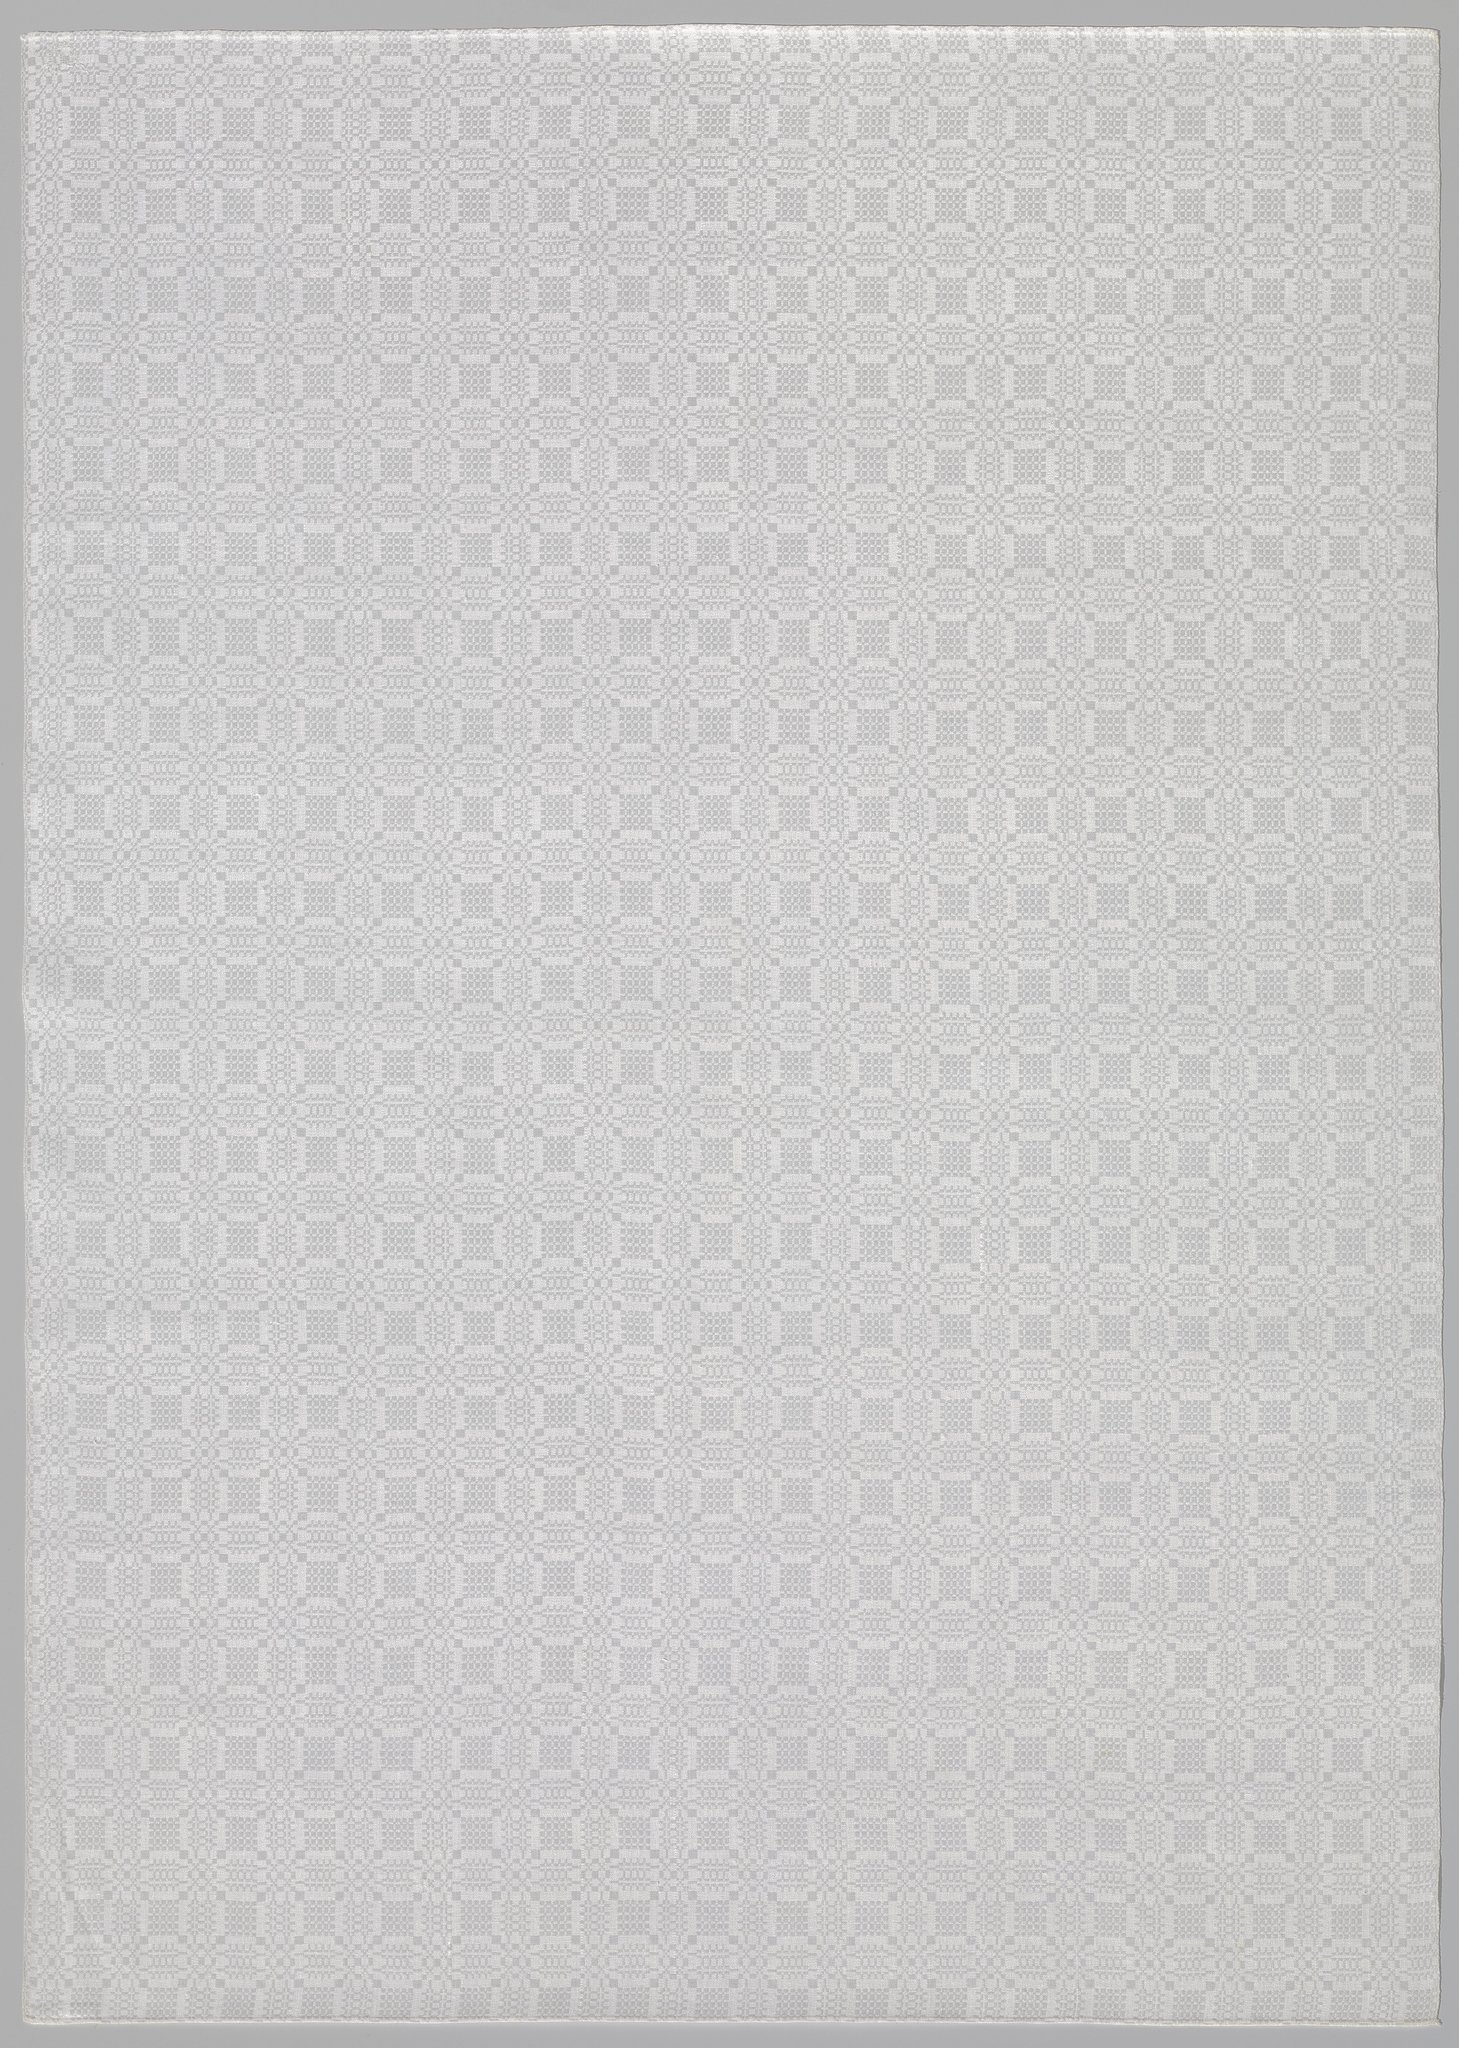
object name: napkin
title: servet met pellenpatroon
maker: Anonymous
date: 1672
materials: linen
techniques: weave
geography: netherlands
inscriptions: mark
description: wit linnen servet met een pellen patroon, merk kroon IVG 1672 WH 2oonl